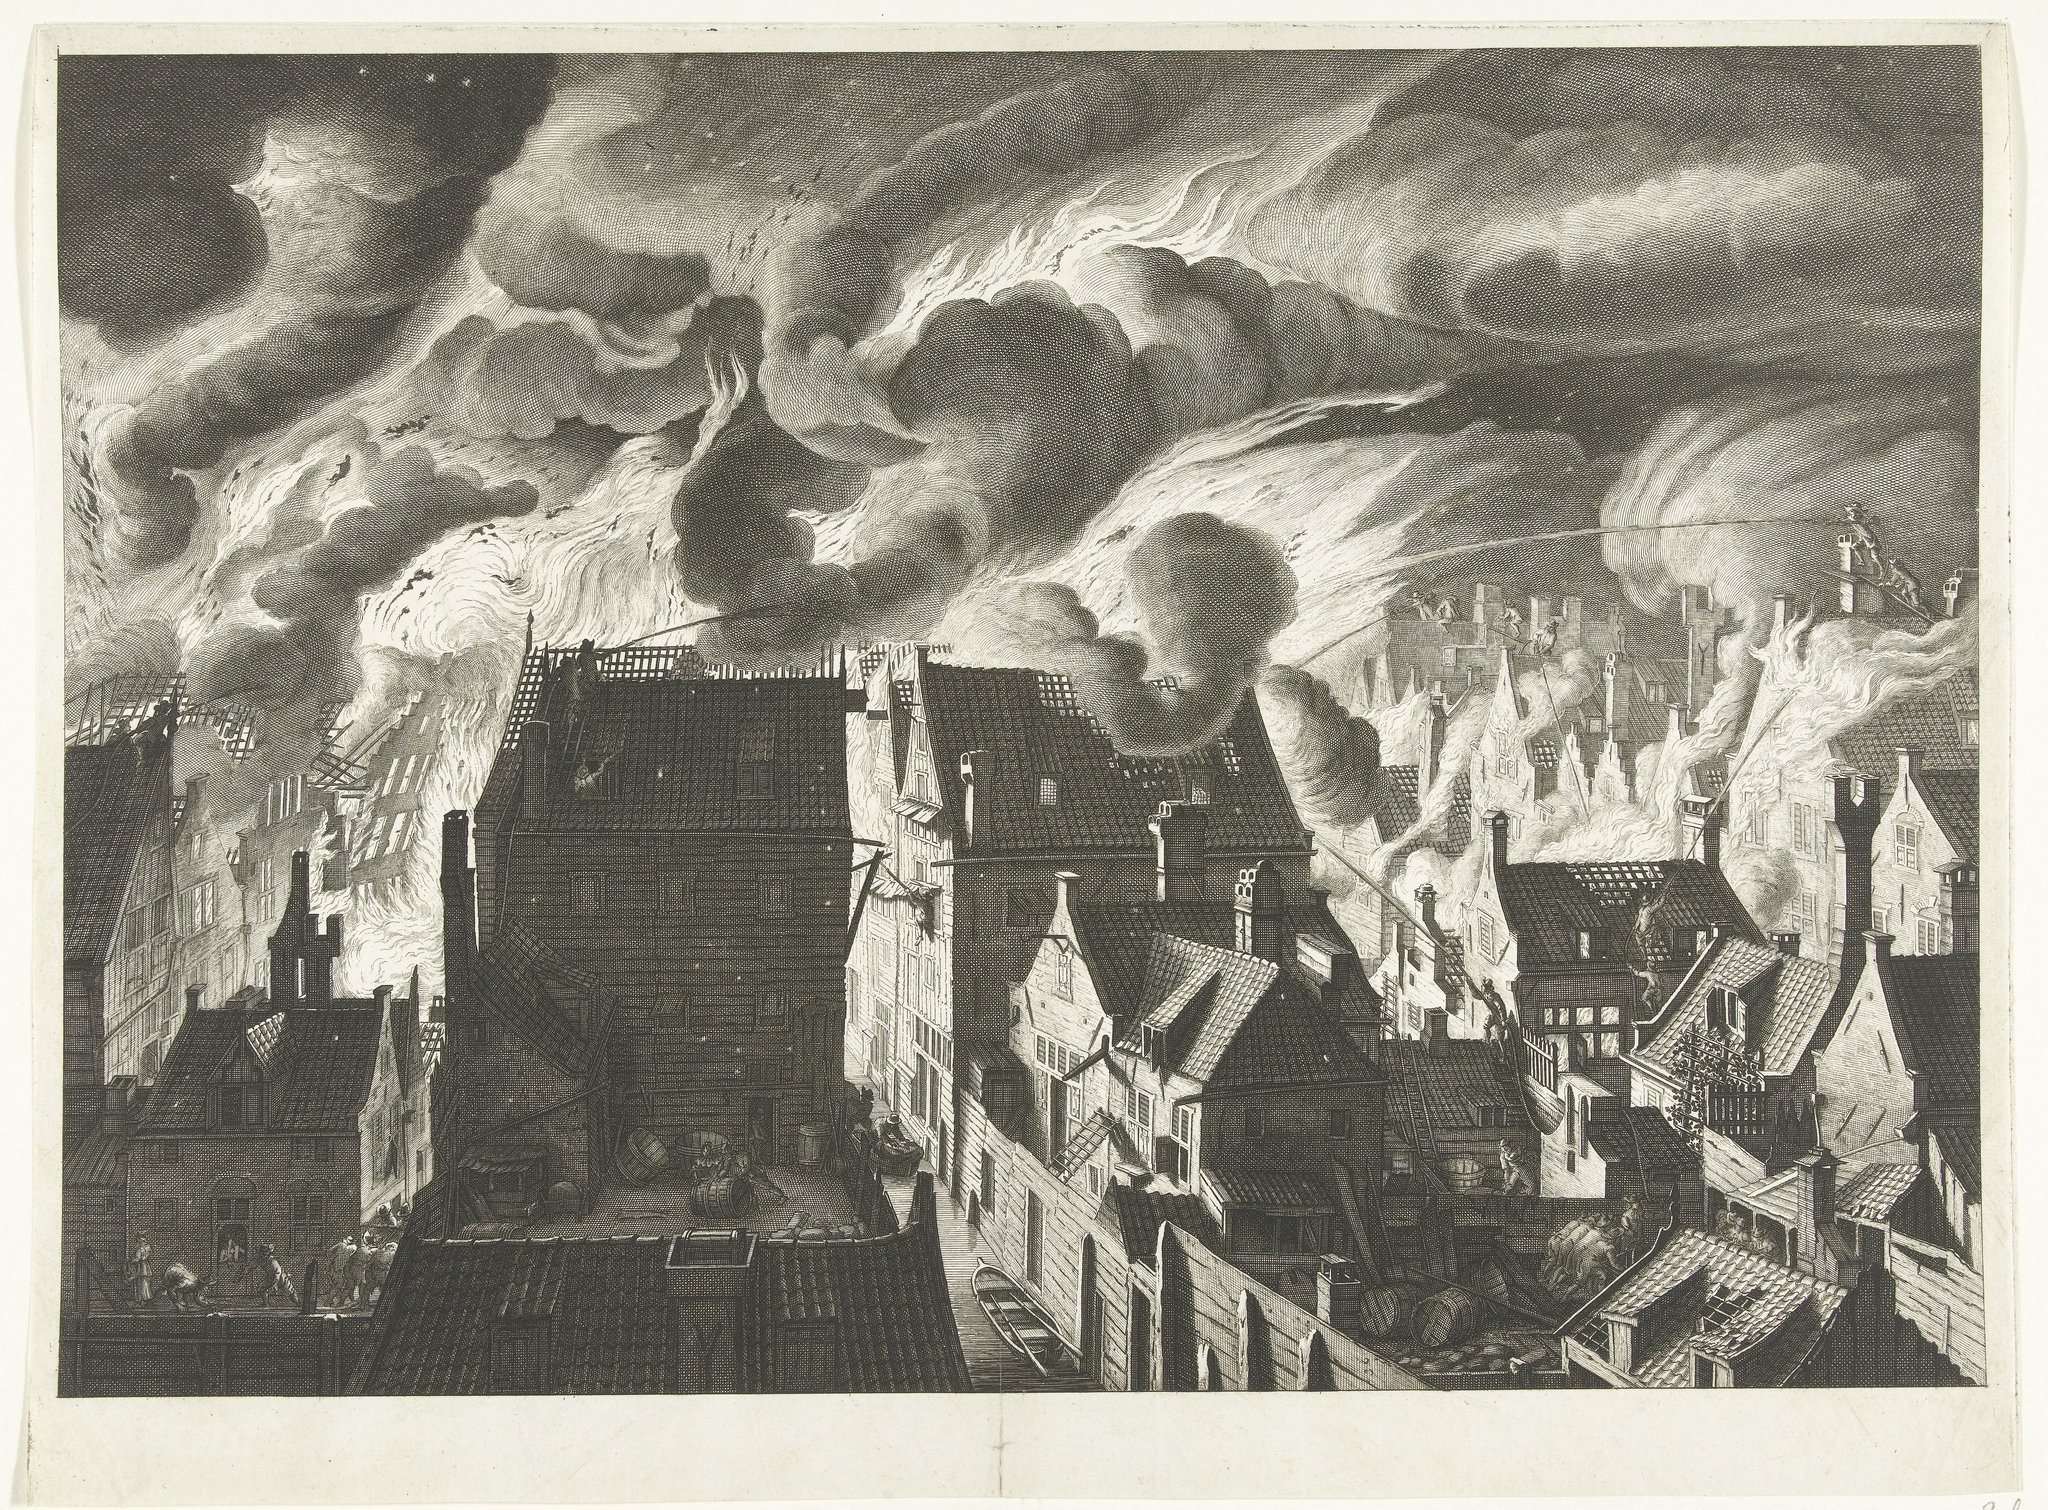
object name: print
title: Het blussen van de zware brand aan de Elandsgracht, 1679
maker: jan van der heyden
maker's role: draughtsman, painter, print maker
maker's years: 1637-1712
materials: paper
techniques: engraving, etching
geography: amsterdam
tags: amsterdam, painter, print maker, draughtsman, jan van der heyden, on fire, ablaze, fire-fighting, fire-extinguishing equipment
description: Latere staat van prent ook gebruikt in: Heyden, Jan van der. Beschryving der nieuwlyks uitgevonden en geoctrojeerde slang-brand-spuiten en haare wyze van brand-blussen, tegenwoordig binnen Amsterdam in gebruik zijnde (…). 1e druk. Amsterdam: Jan Rieuwertsz. (II), 1690. En in: Heyden, Jan van der. Beschryving der nieuwlyks uitgevonden en geoctrojeerde slang-brand-spuiten en haare wyze van brand-blussen, tegenwoordig binnen Amsterdam in gebruik zijnde (…). 2e druk. Amsterdam: erfgenamen Jan van der Heyden, 1735. Voor latere (geletterde) staat zie RP-P-AO-28-76-5, RP-P-OB-79.499, RP-P-OB-103.459 en RP-P-1921-311.